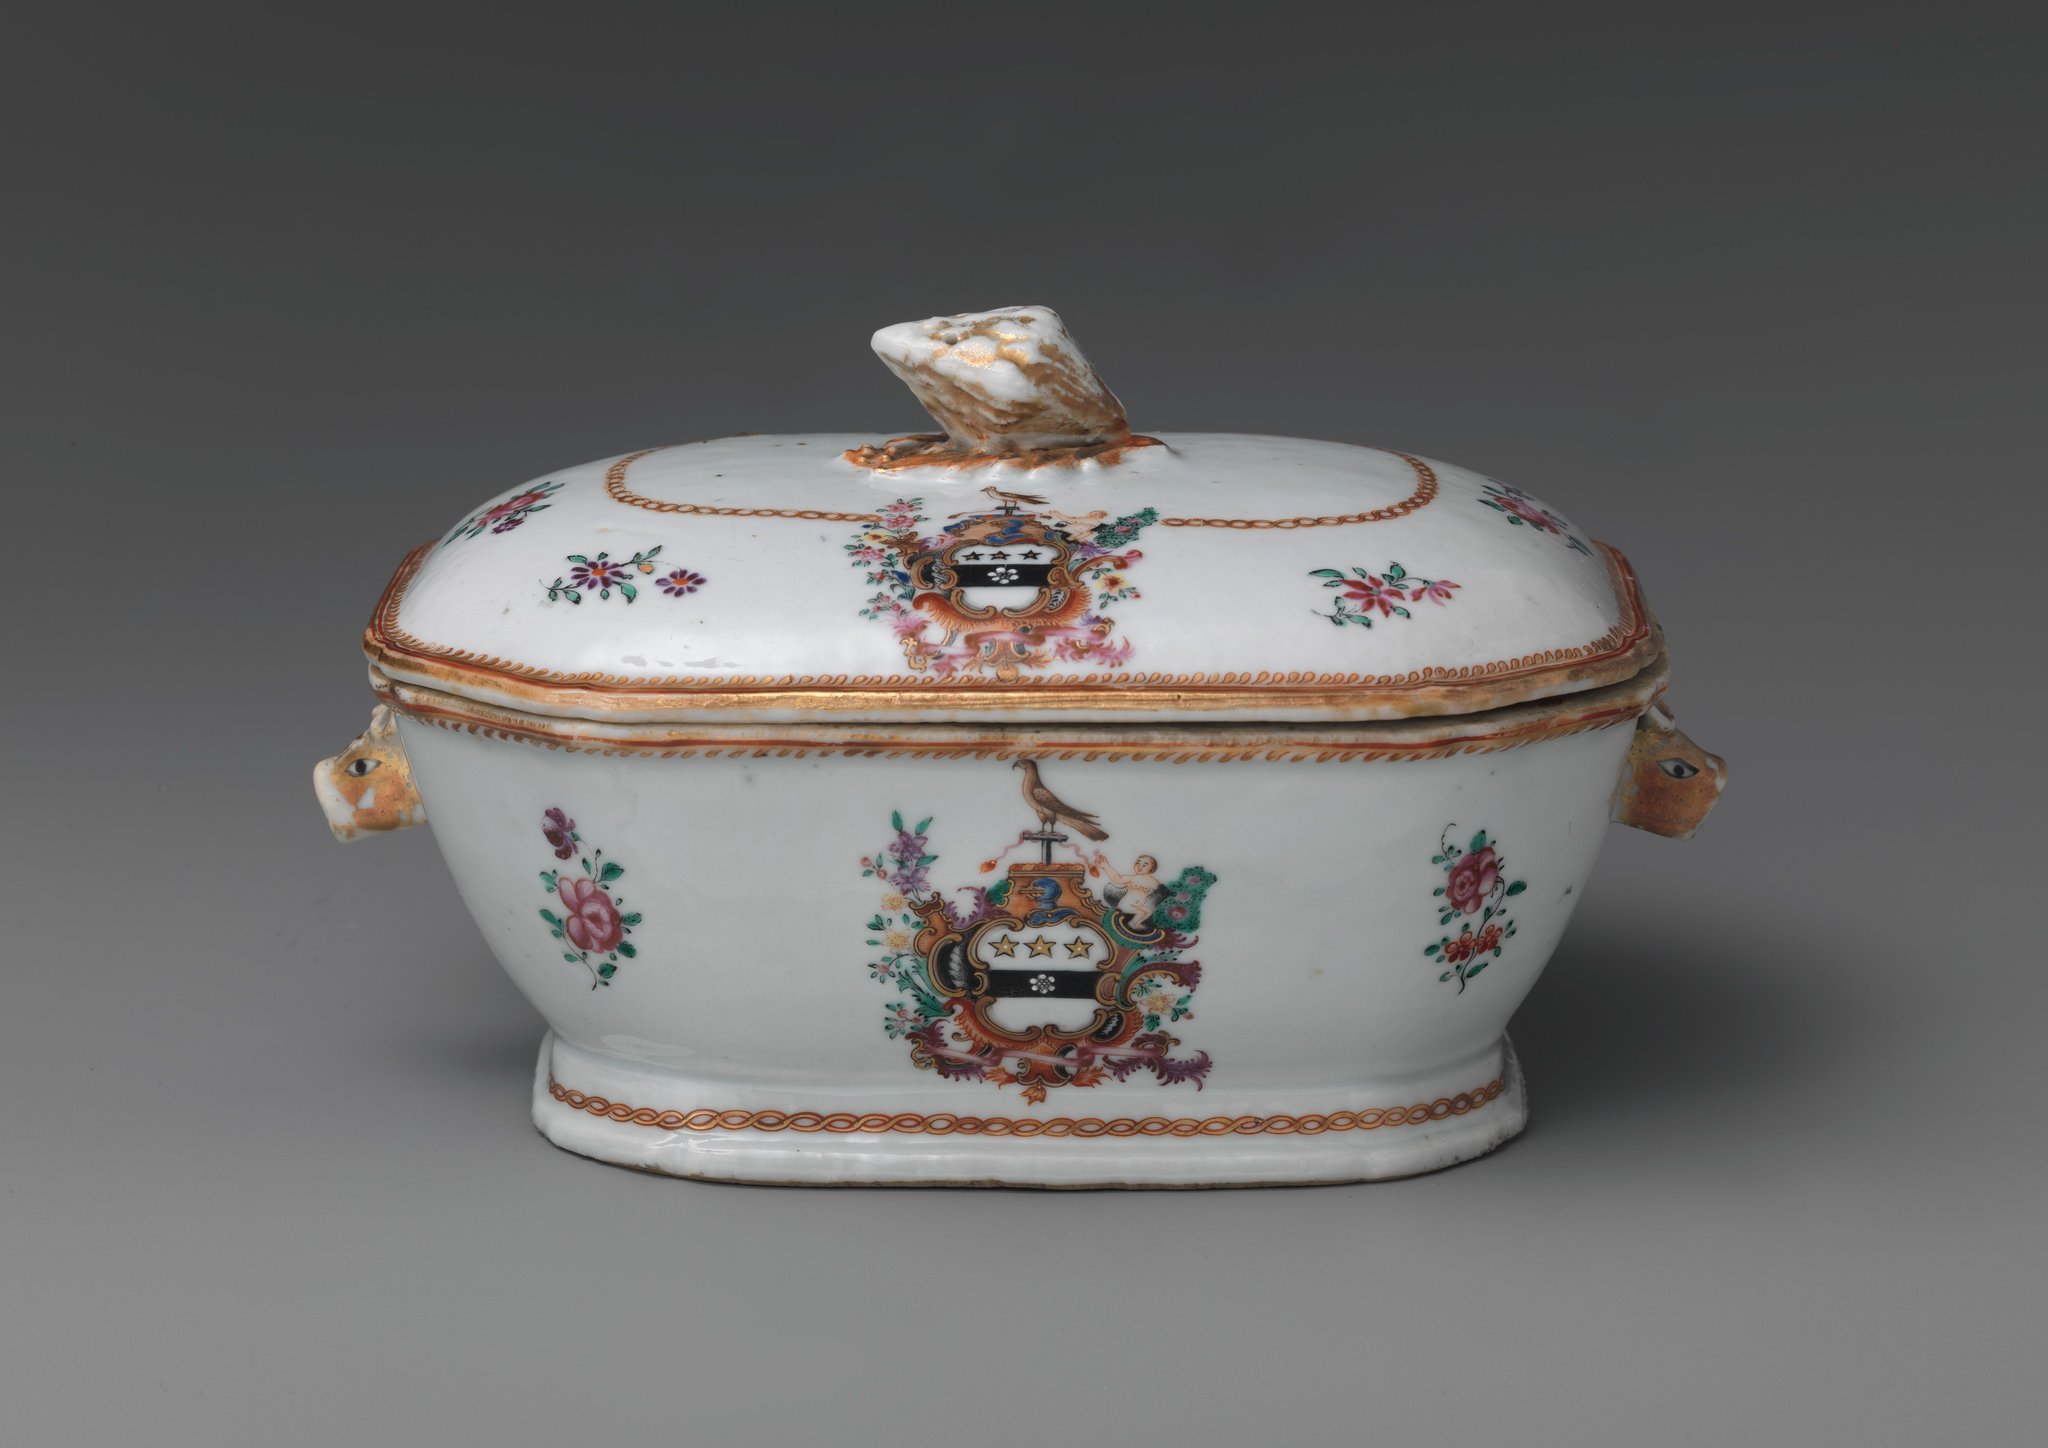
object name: sauce tureen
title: Covered Sauce Tureen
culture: chinese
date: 1785-1790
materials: porcelain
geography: china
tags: birds,coat of arms